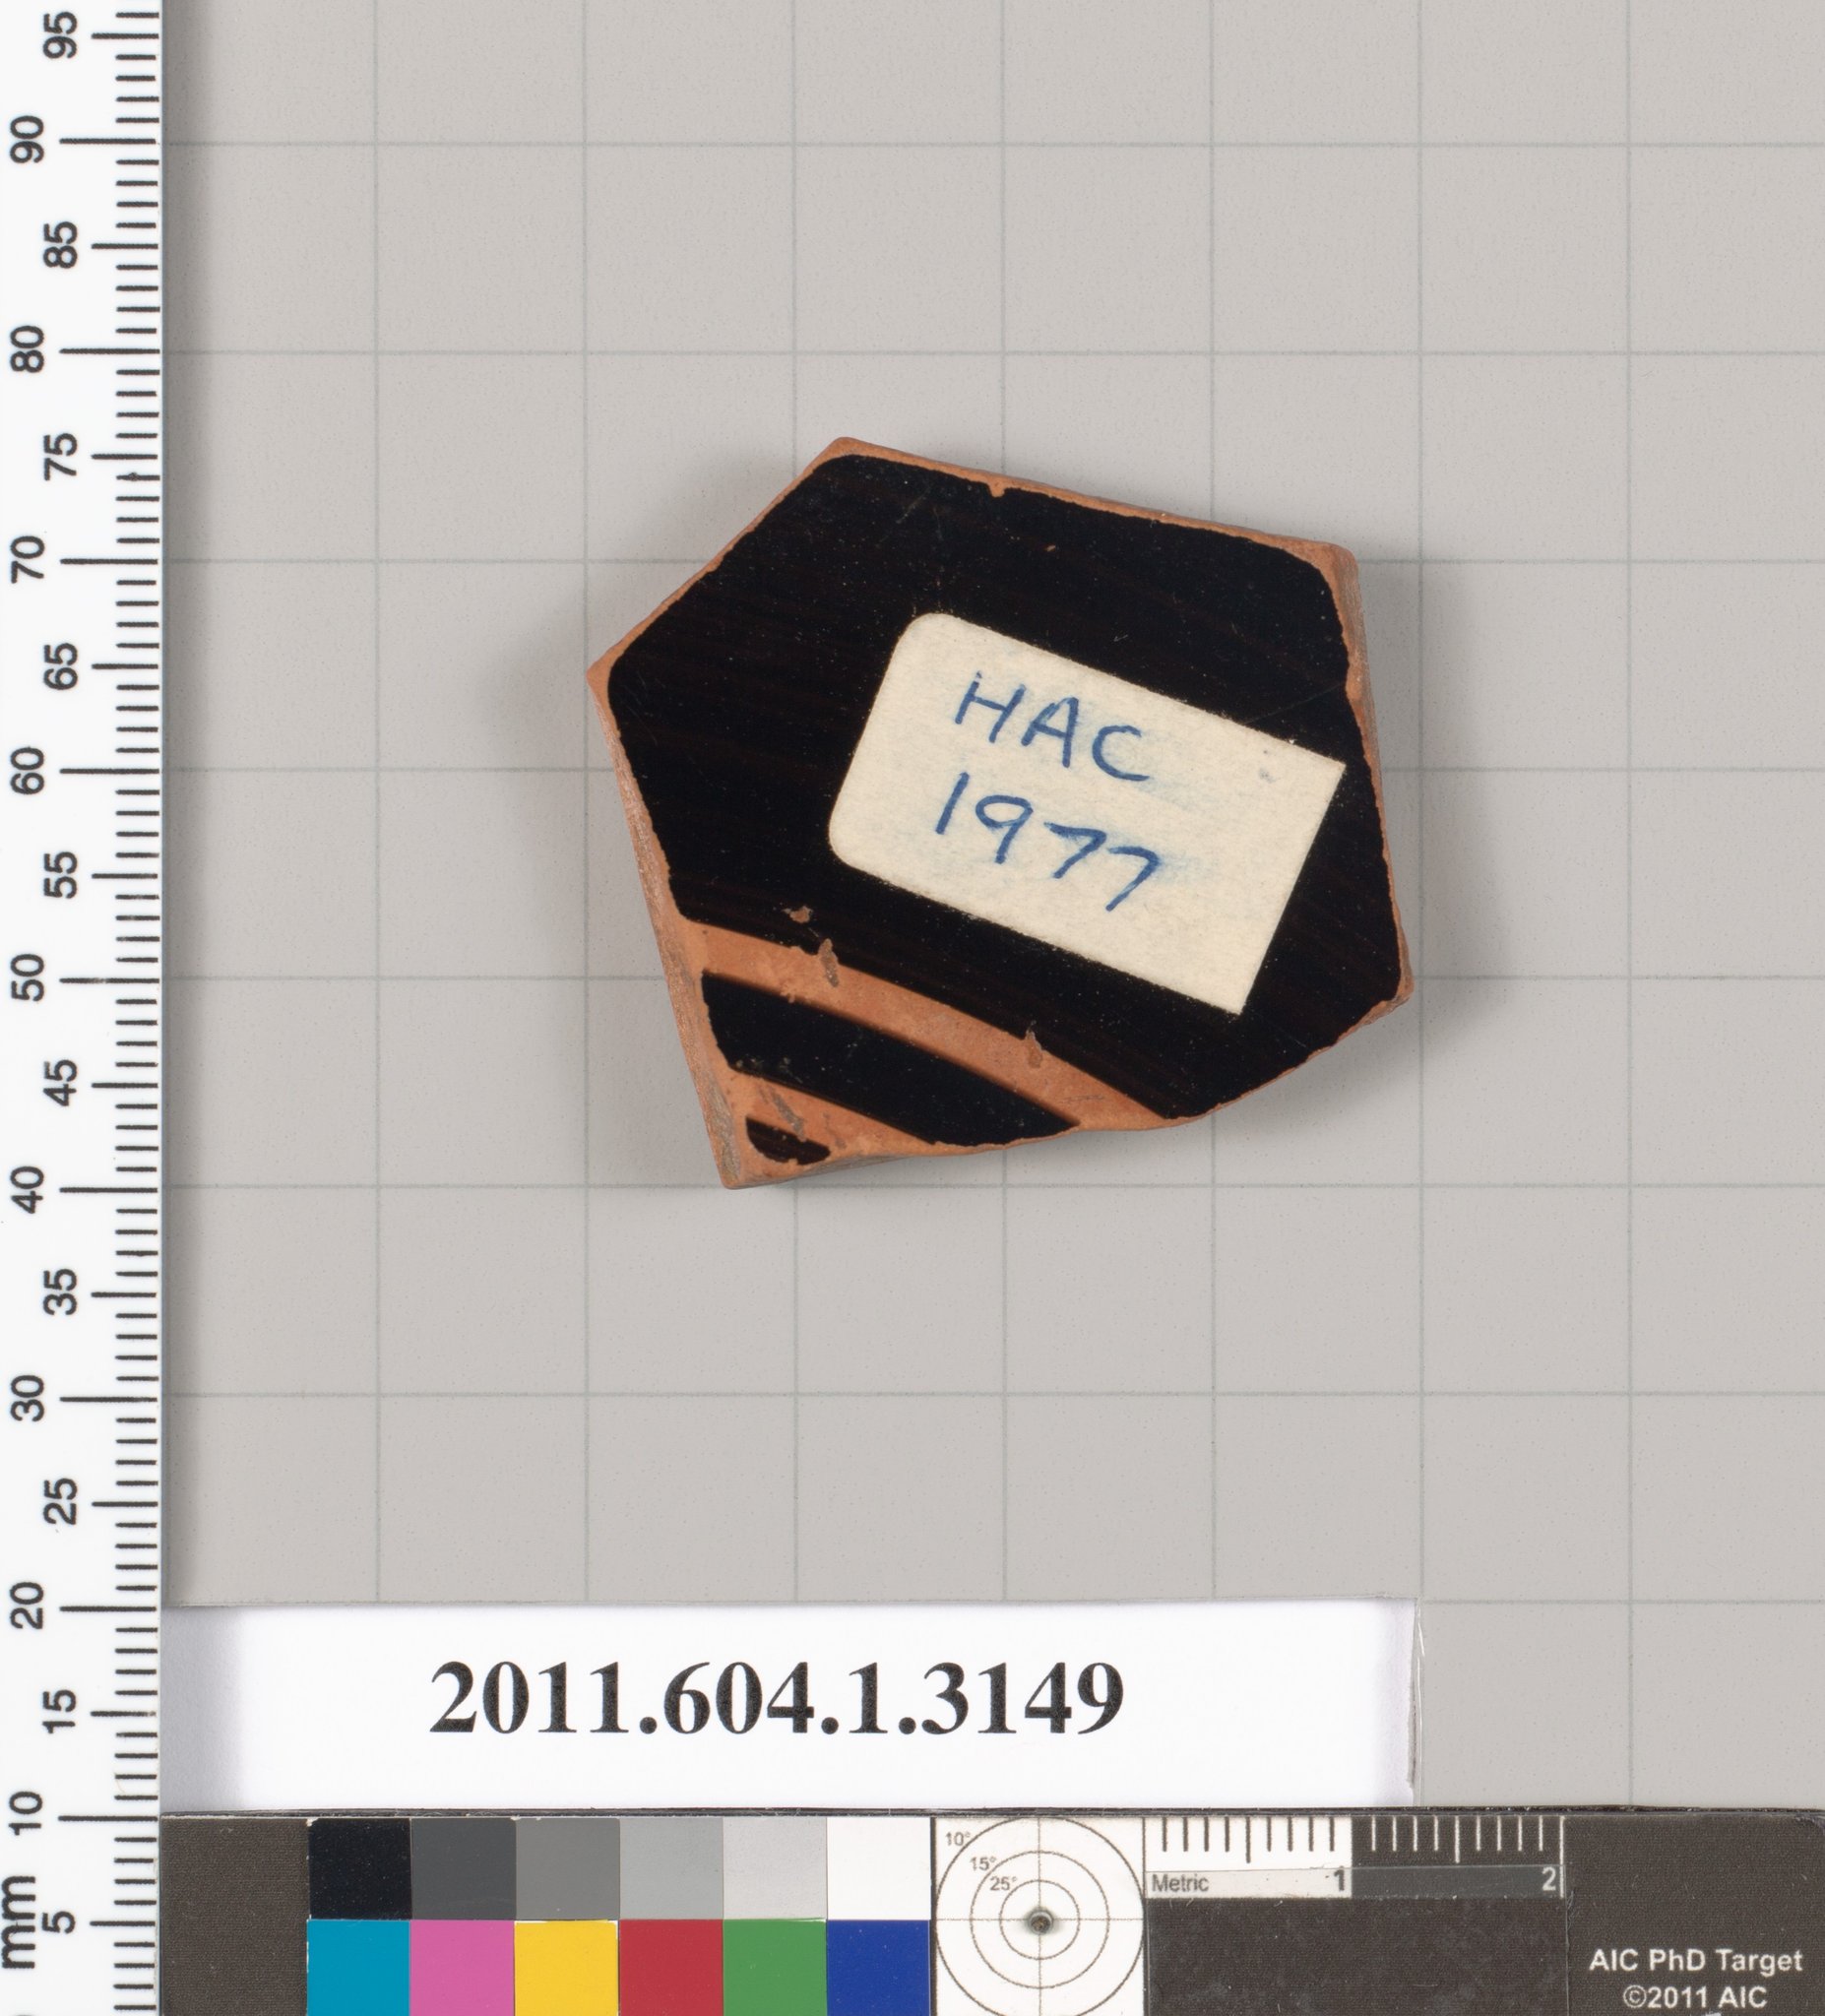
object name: kylix fragment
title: Terracotta fragment of a kylix (drinking cup)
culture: greek, attic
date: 450-426 BCE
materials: terracotta